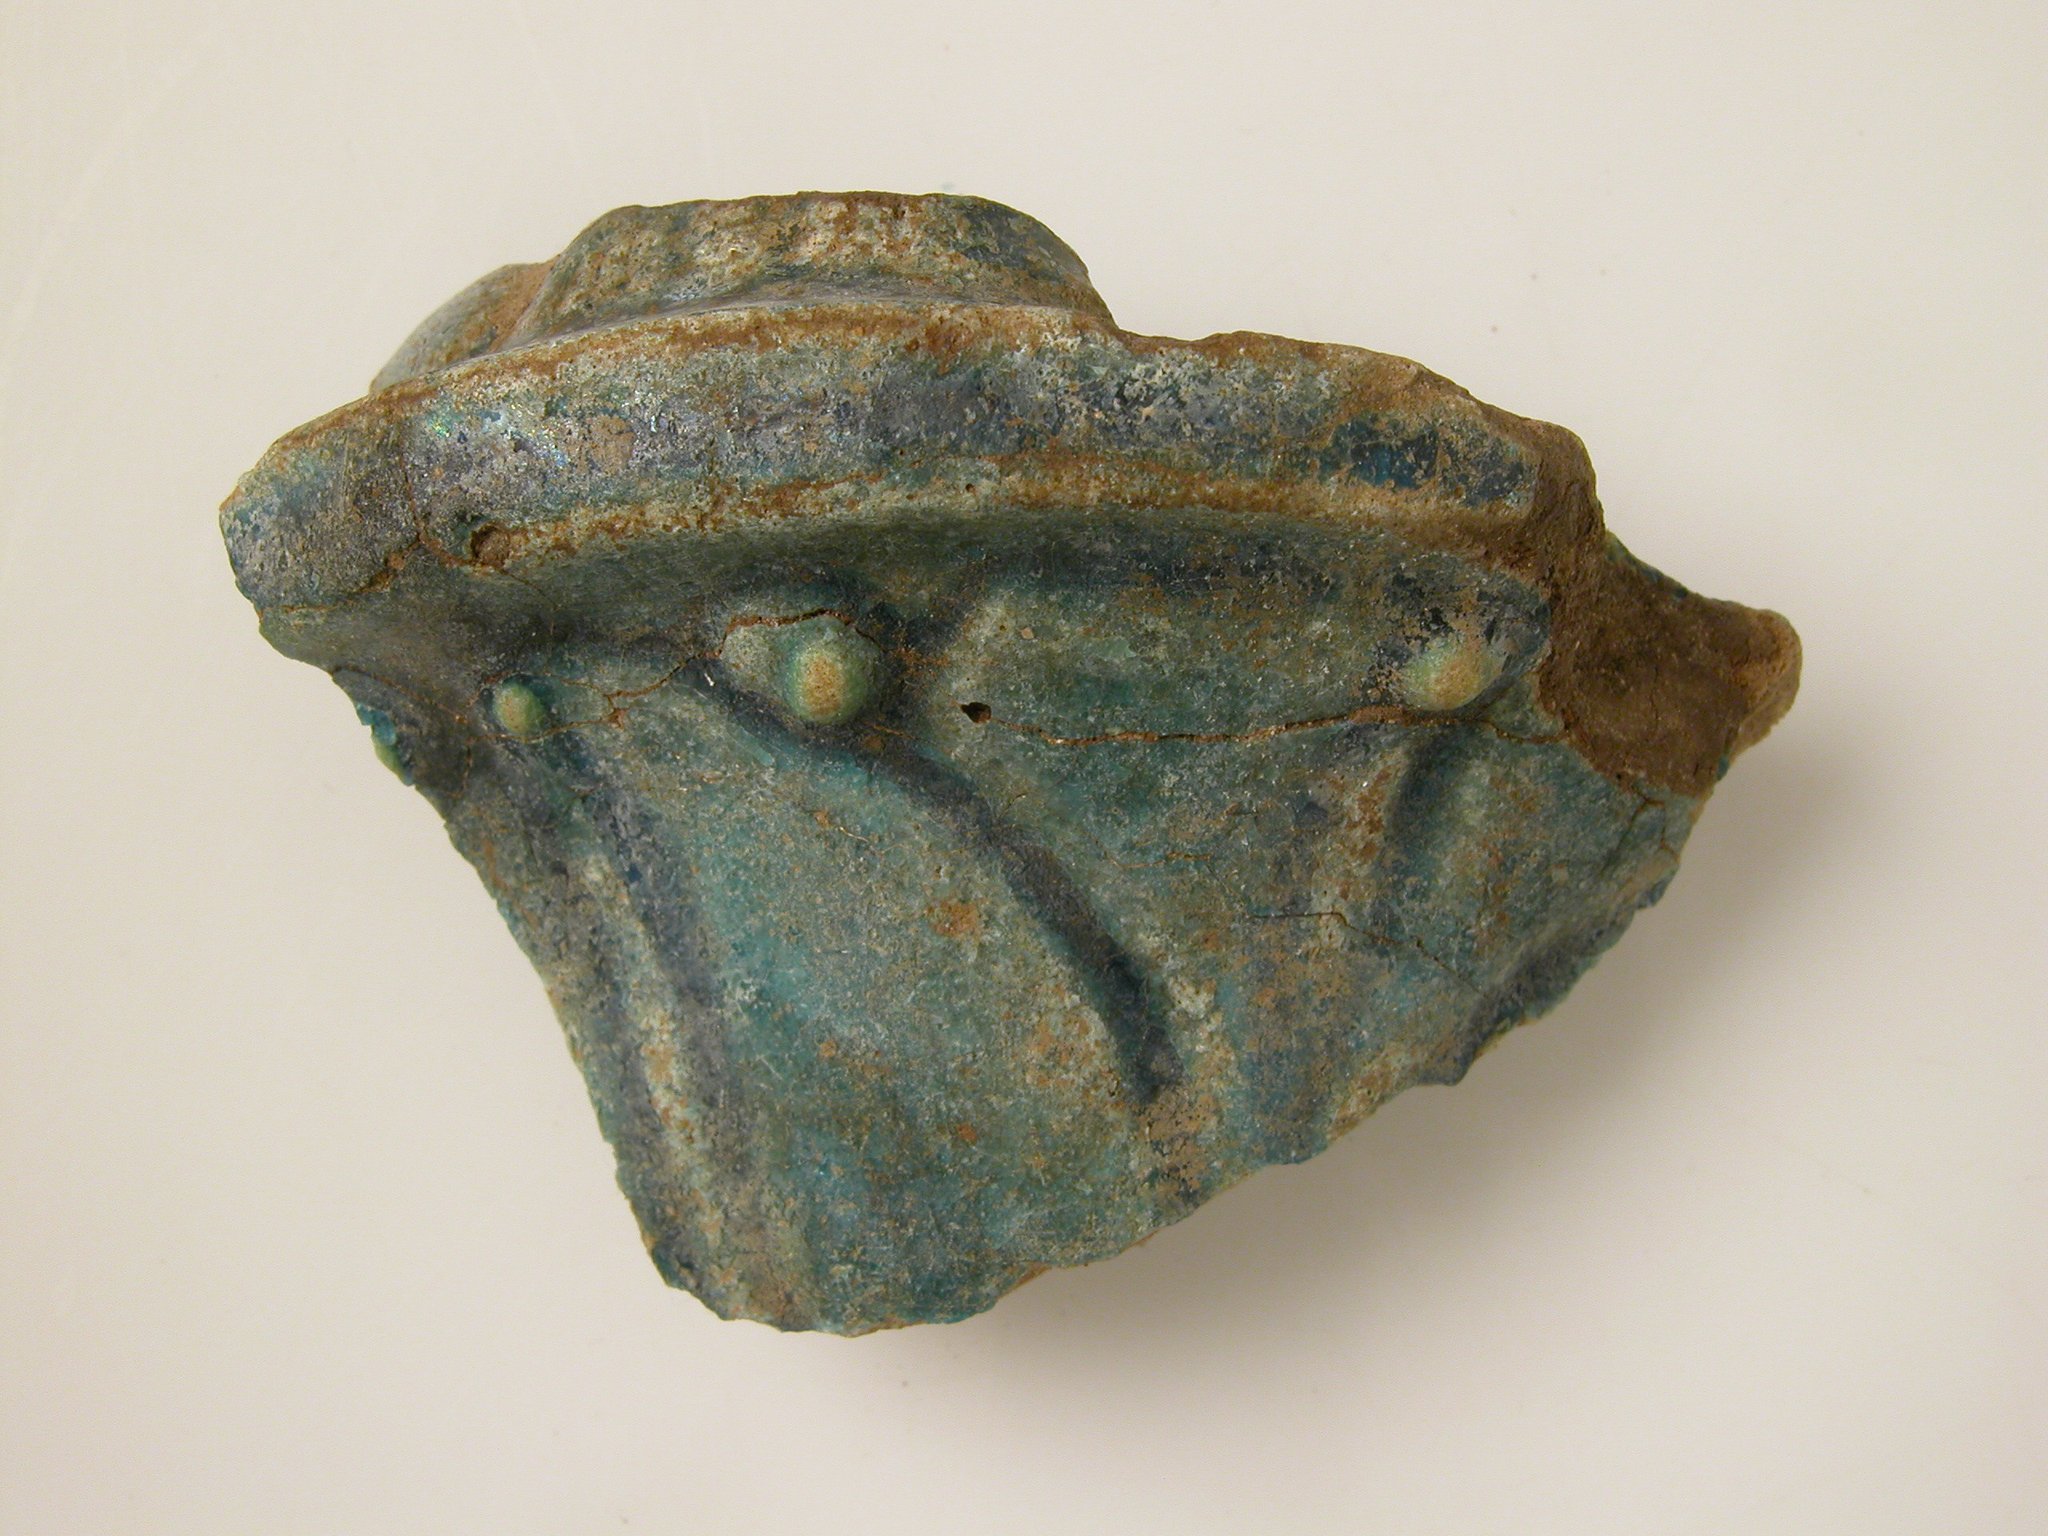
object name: fragment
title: Pottery Fragment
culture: coptic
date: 301-700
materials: earthenware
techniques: glazing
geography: egypt